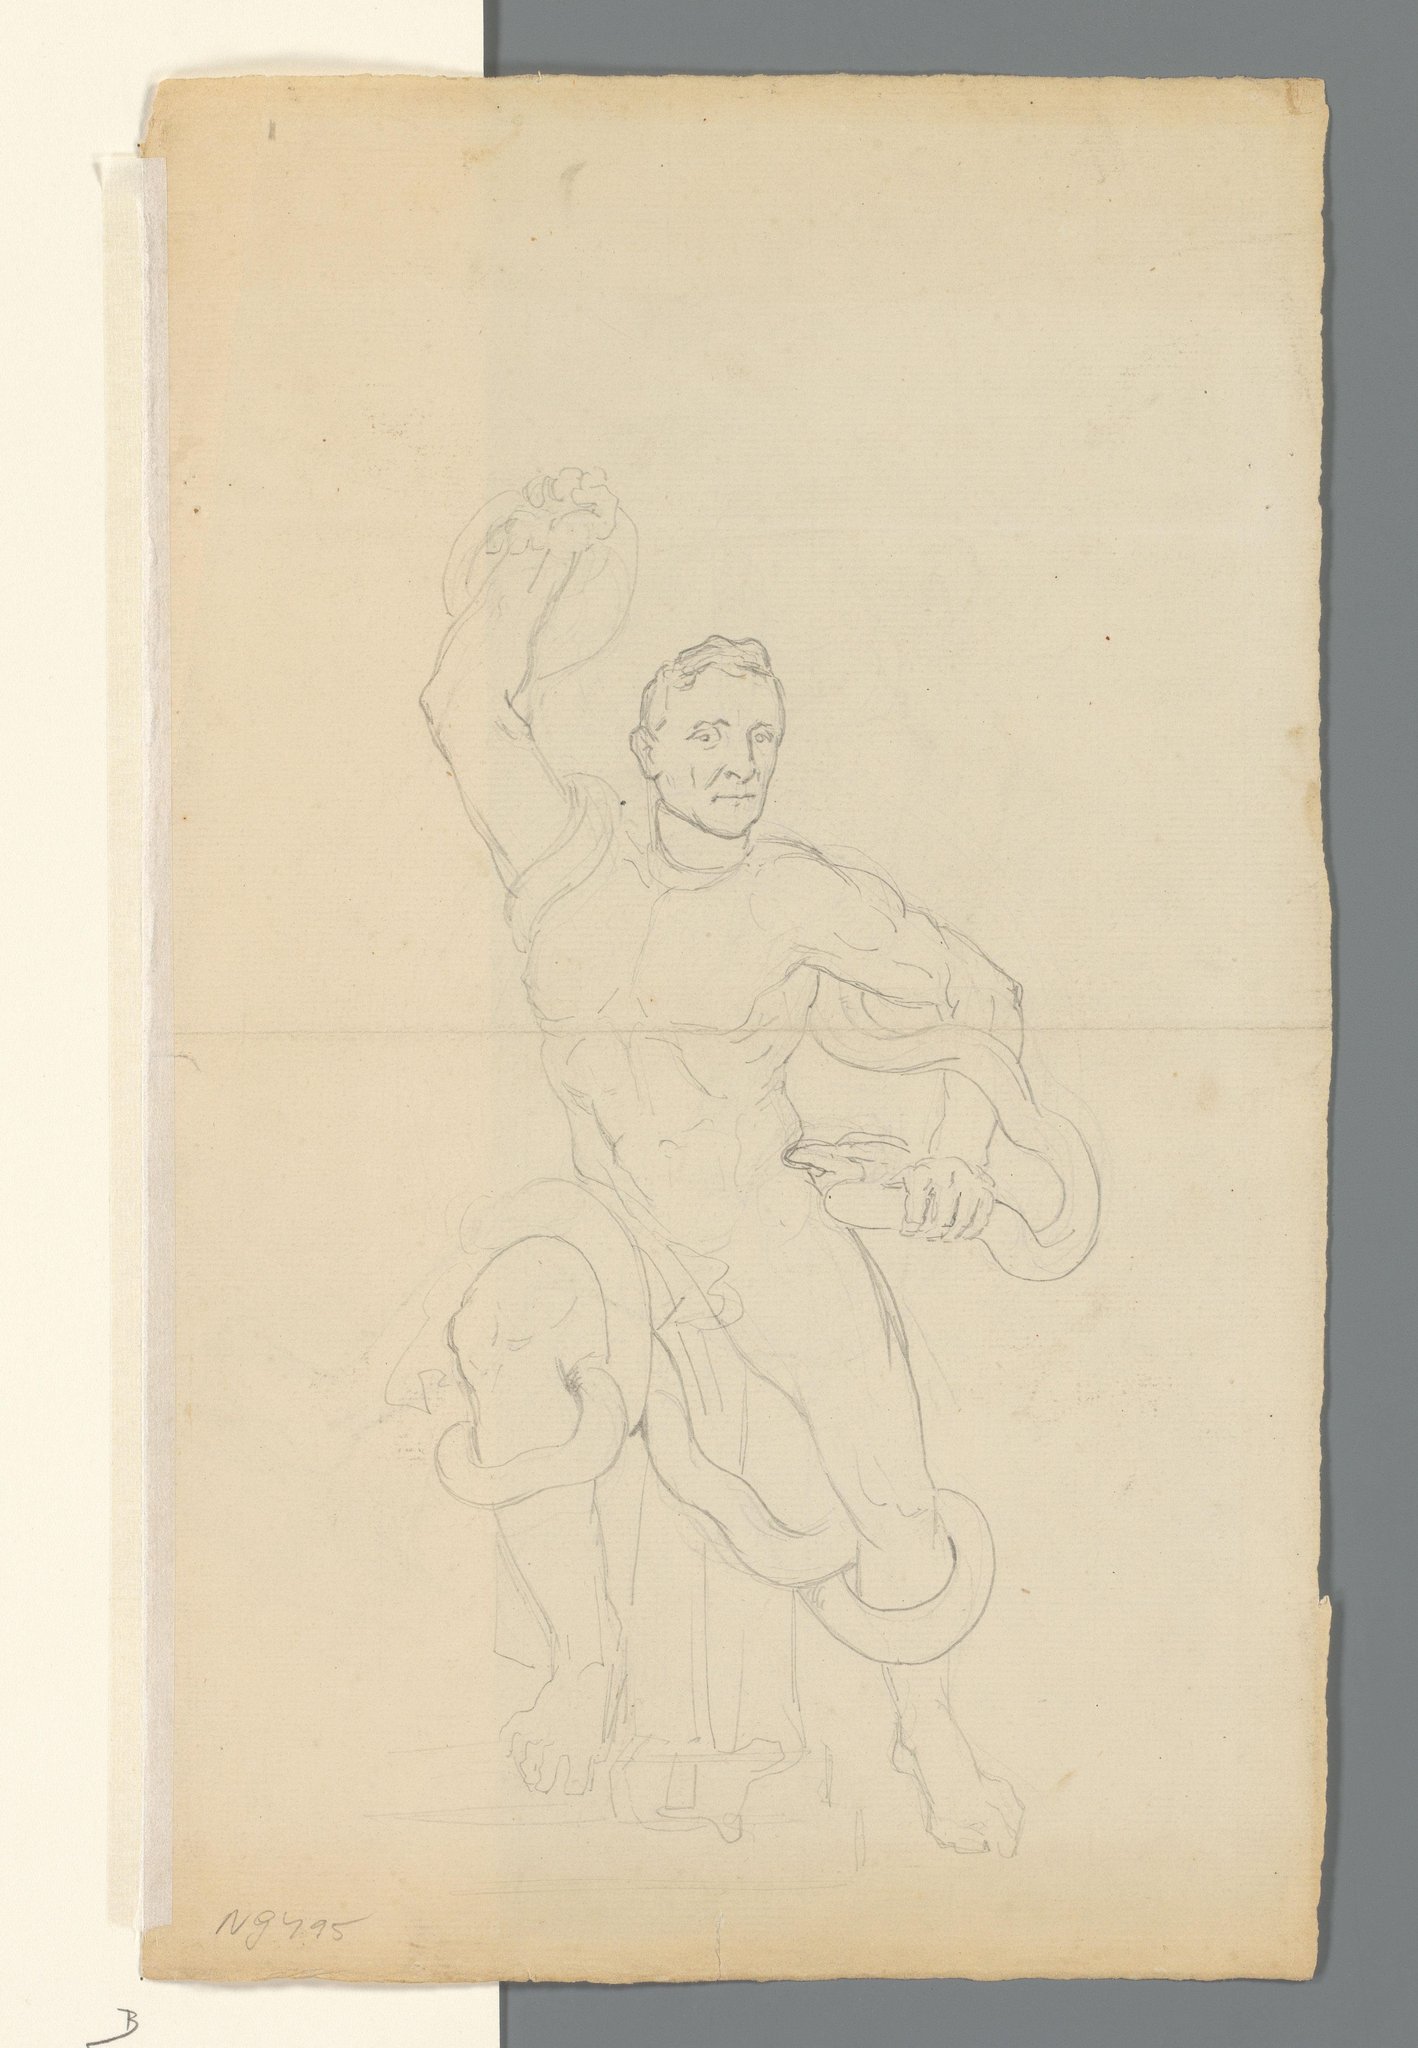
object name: preparatory study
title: Politicus als Laocoön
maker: johan michaël schmidt crans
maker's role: draughtsman, print maker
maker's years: 1830-1907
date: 1880-1890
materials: paper, pencil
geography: netherlands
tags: netherlands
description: Een (onbekende) politicus als de priester Laocoön in het beeldhouwwerk van de Laocoöngroep. Waarschijnlijk een schets voor een spotprent in De Nederlandsche Spectator.